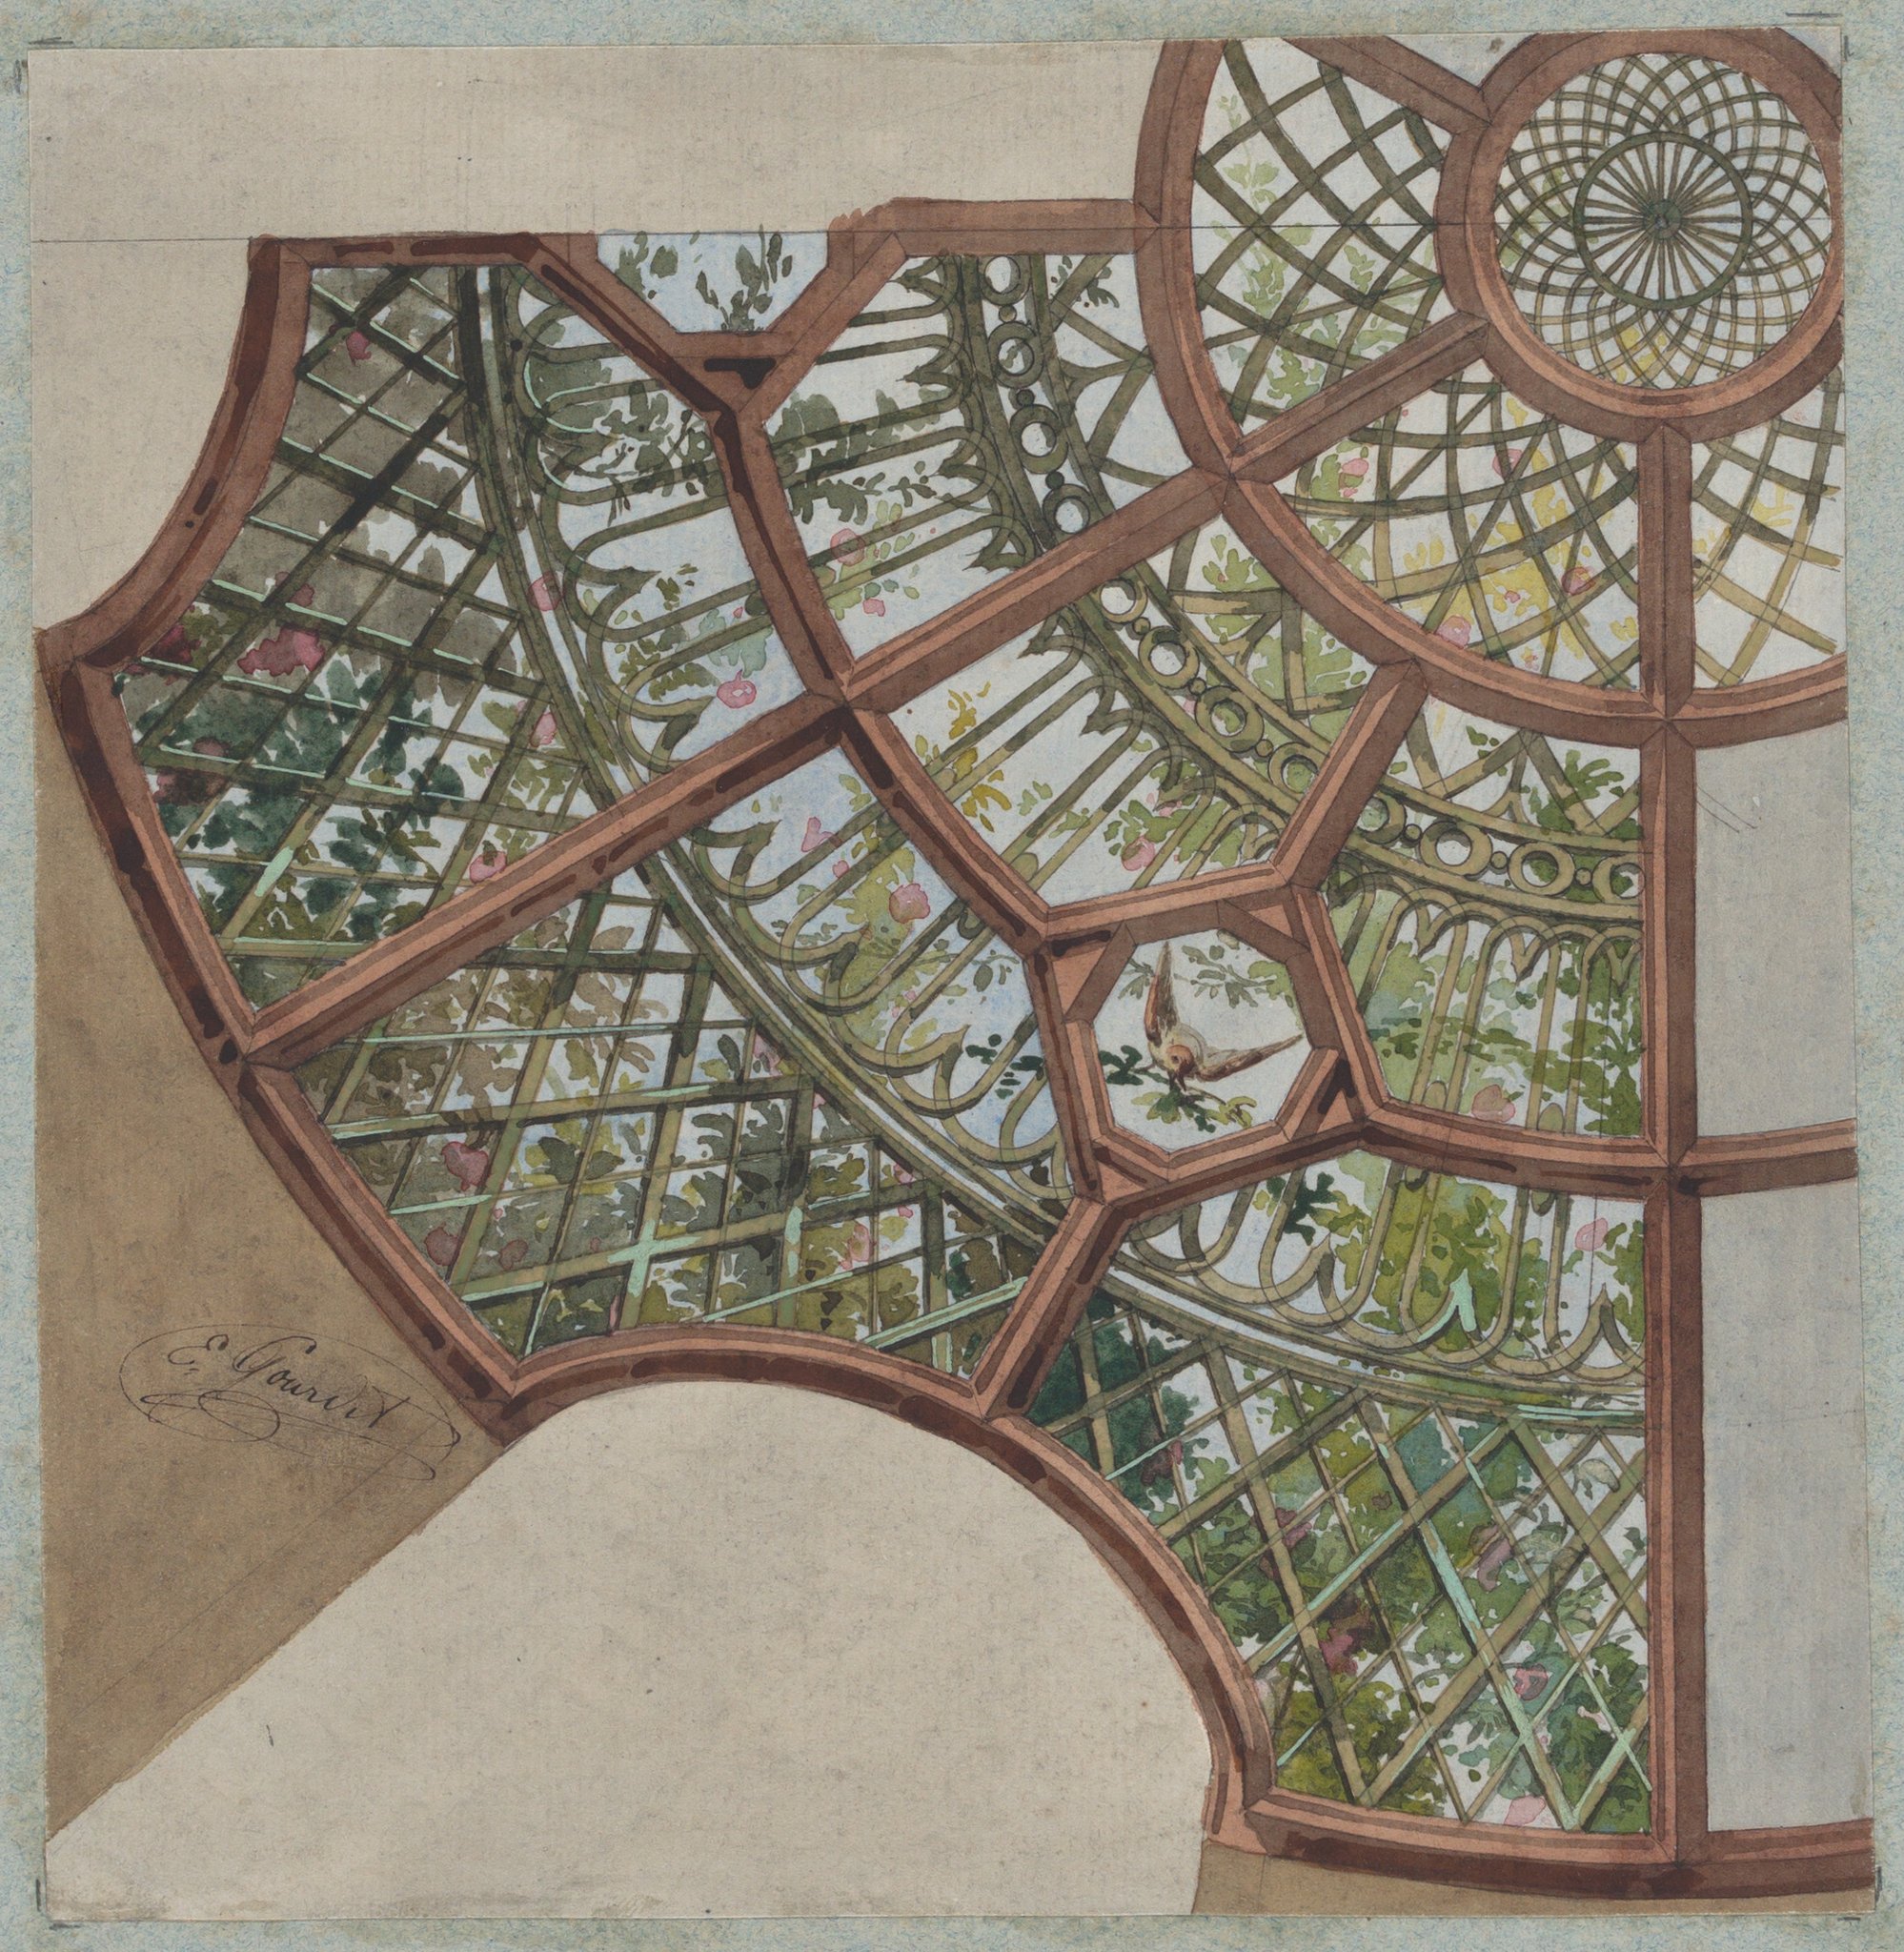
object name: drawing ornament architecture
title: Design for a ceiling with lattice work and flowering vines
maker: jules-edmond-charles lachaise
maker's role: artist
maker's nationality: french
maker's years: 1897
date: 1851-1900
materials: graphite, ink, paper, watercolor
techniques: pen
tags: flowers